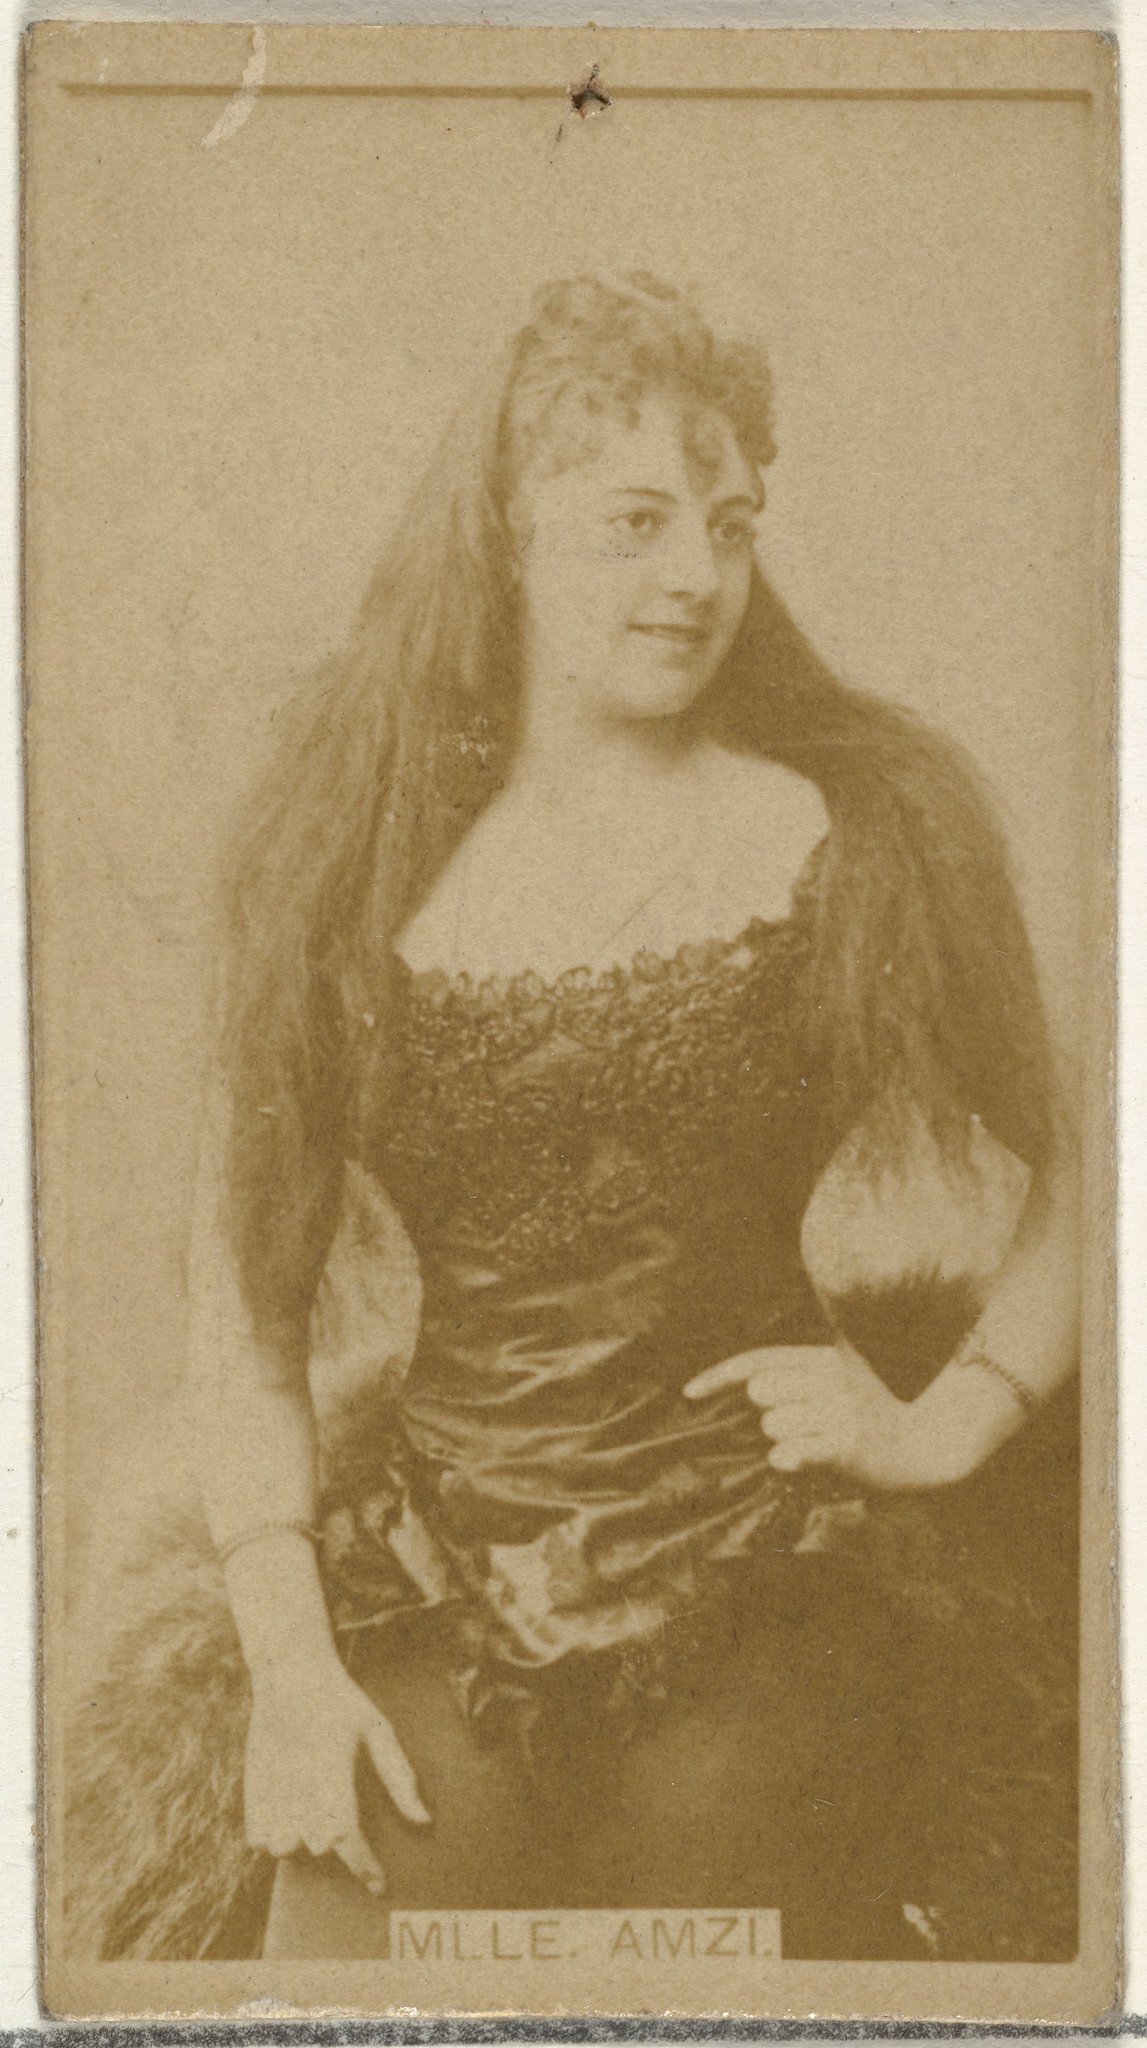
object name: photograph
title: Mlle. Amzi, from the Actors and Actresses series (N145-8) issued by Duke Sons & Co. to promote Duke Cigarettes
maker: w. duke, sons & co.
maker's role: publisher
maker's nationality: american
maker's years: 1870-1920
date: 1891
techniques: albumen silver print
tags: portraits,women,actresses